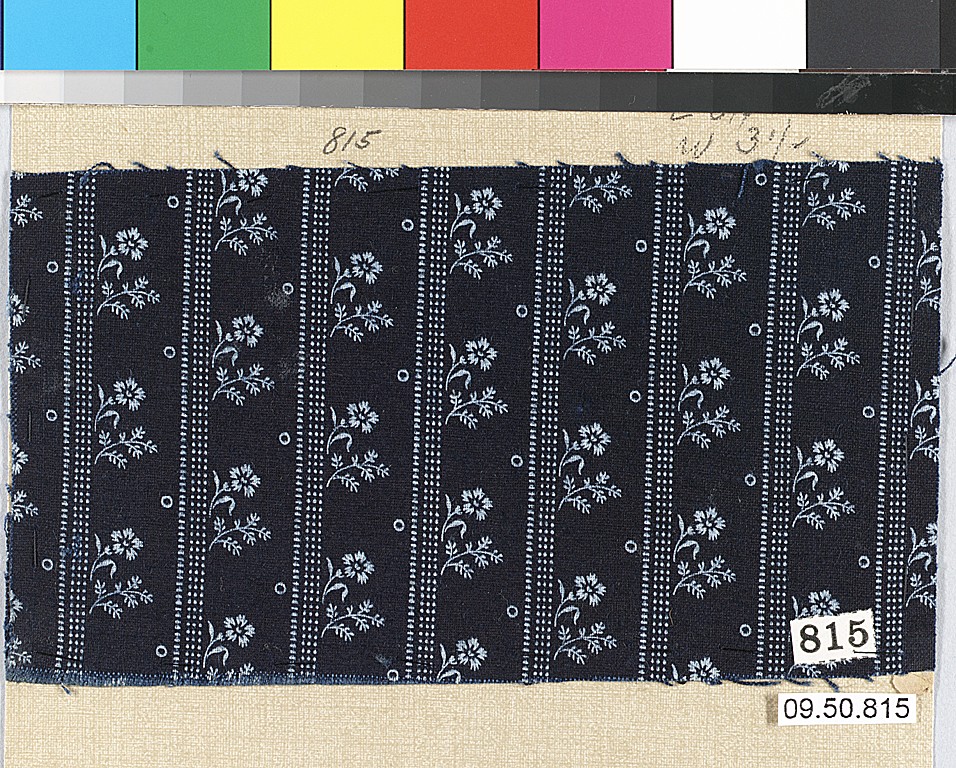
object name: piece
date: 1801-1900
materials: cotton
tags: flowers,leaves